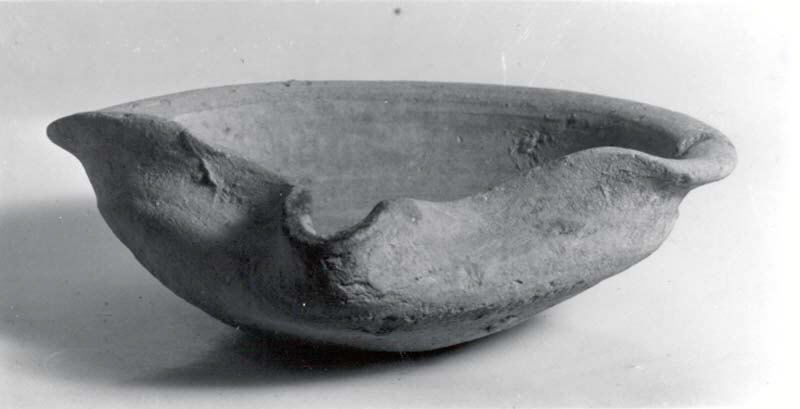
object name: lamp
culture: israelite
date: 734-601 BCE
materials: ceramic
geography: levant